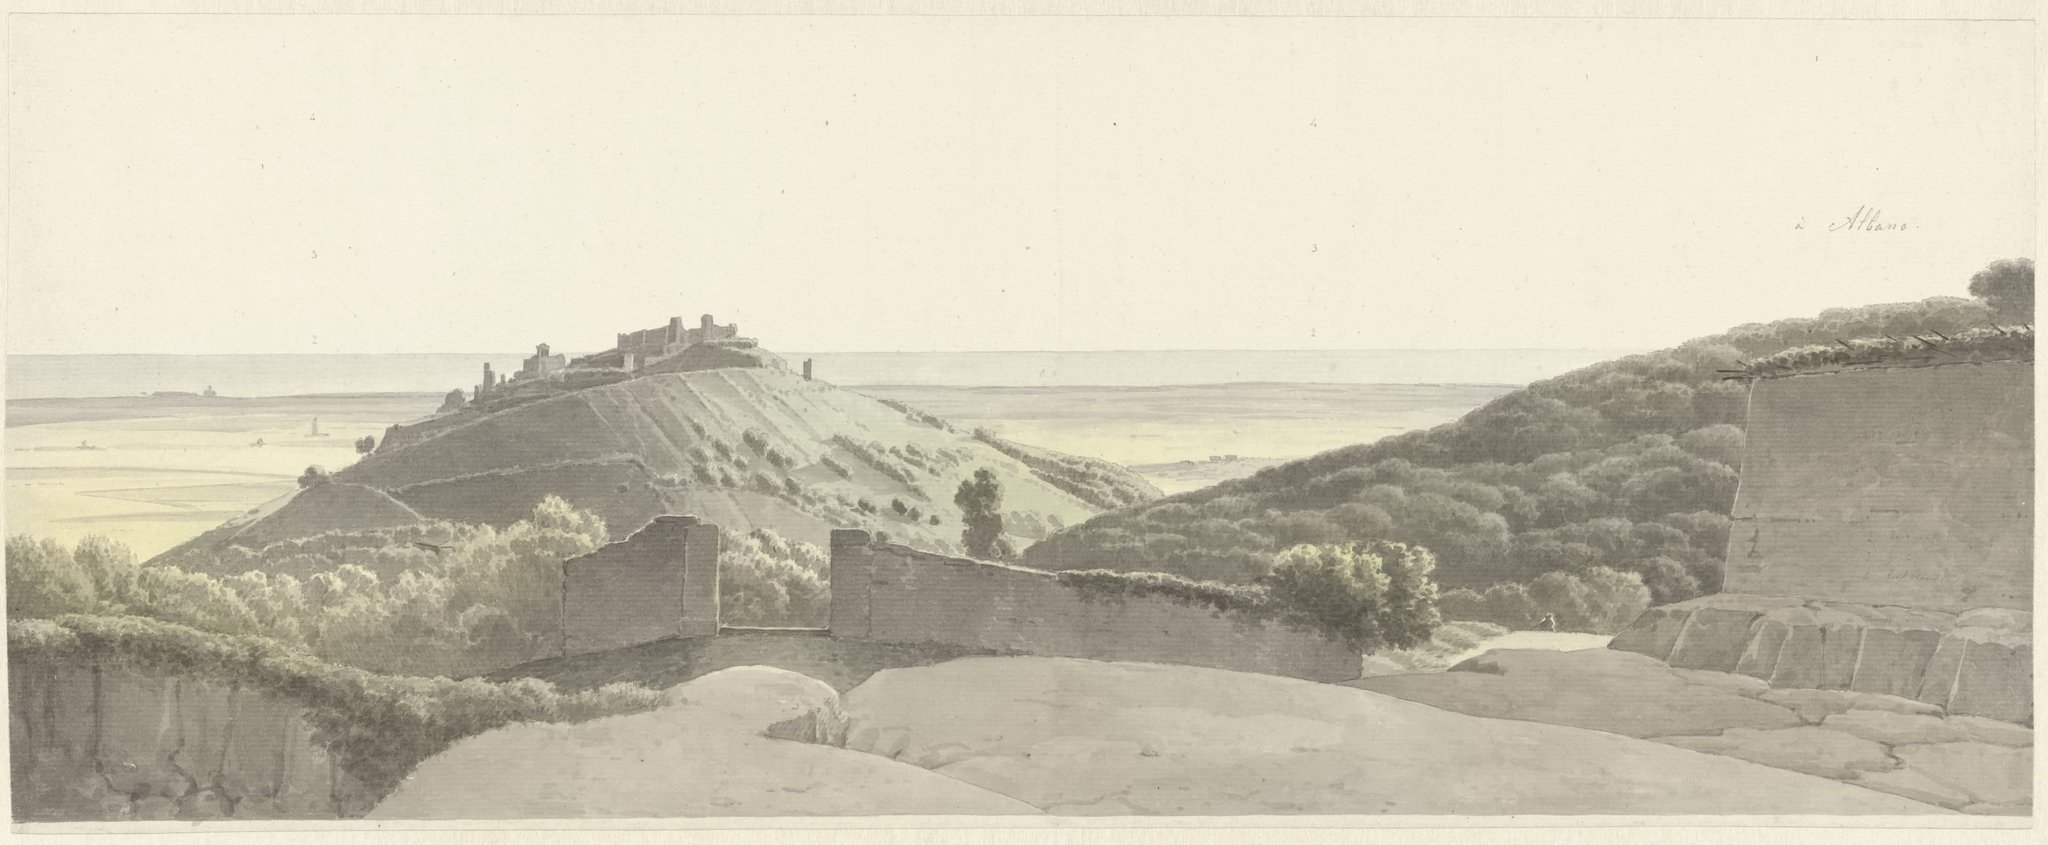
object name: drawing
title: Landscape around Albano Laziale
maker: josephus augustus knip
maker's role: draughtsman, painter, print maker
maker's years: 1777-1847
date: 1809-1812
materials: graphite, paper, watercolor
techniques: brush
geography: italy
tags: low hill country, italy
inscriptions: inscription: ‘à Albano’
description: Knip here drew the Castello Savelli, a medieval fortress atop a hill on the outskirts of Albano Laziale. The castle had been uninhabited since the end of the 18th century, and little by little had fallen into a state of disrepair. What remained was an exceptionally picturesque ruin situated in a splendid landscape.